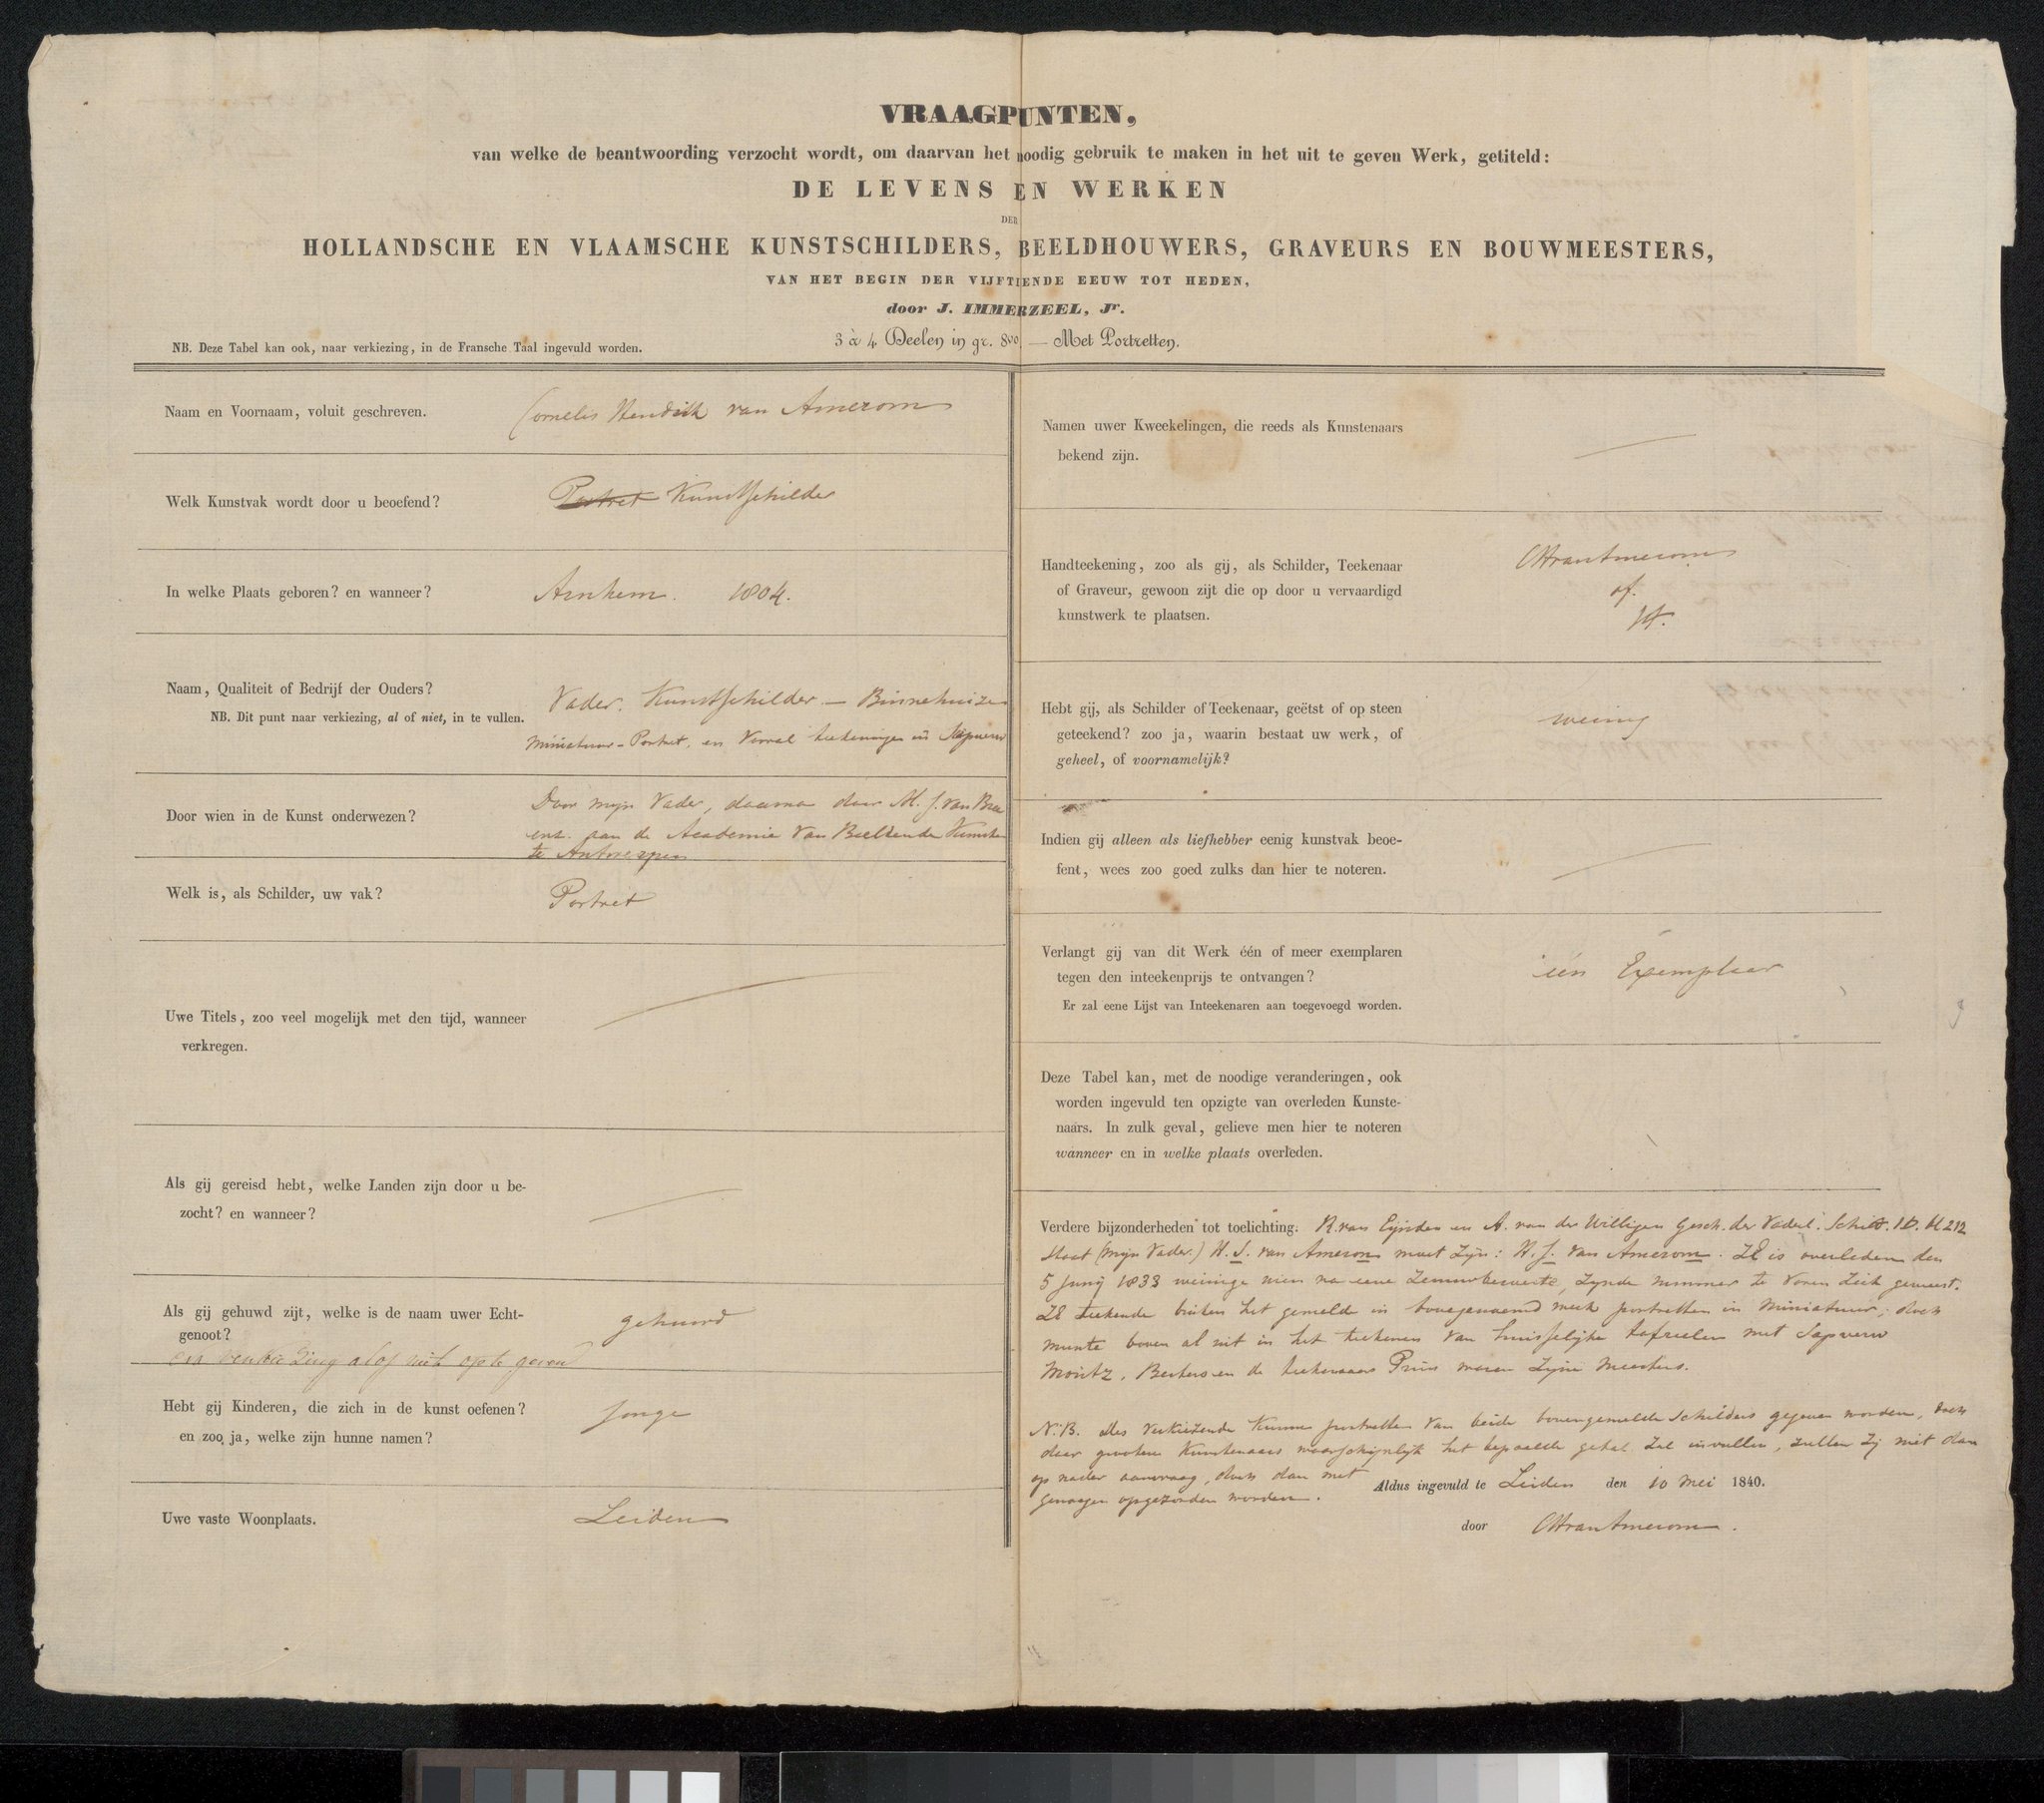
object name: manuscript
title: Enquêteformulier ingevuld door Cornelis Hendrik van Amerom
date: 1840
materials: ink, paper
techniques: pen, printing, writing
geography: leiden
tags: cornelis hendrik van amerom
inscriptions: inscription: ‘Vraagpunten,/ van welke de beantwoording verzocht wordt, om daarvan het noodig gebruik te maken in het uit te geven Werk, getiteld: De levens en werken/ der Hollandsche en Vlaamsche kunstschilders, beeldhouwers,/ graveurs en bouwmeesters, van het begin der vijftiende eeuw tot heden/ door J. Immerzeel, Jr.’, watermark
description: Opgenomen in: Immerzeel, J. Jr., De levens en werken der Hollandsche en Vlaamsche kunstschilders, beeldhouwers, graveurs en bouwmeesters, van het begin der vijftiende eeuw tot heden, Amsterdam: J.C. van Kesteren, 1842-1843.